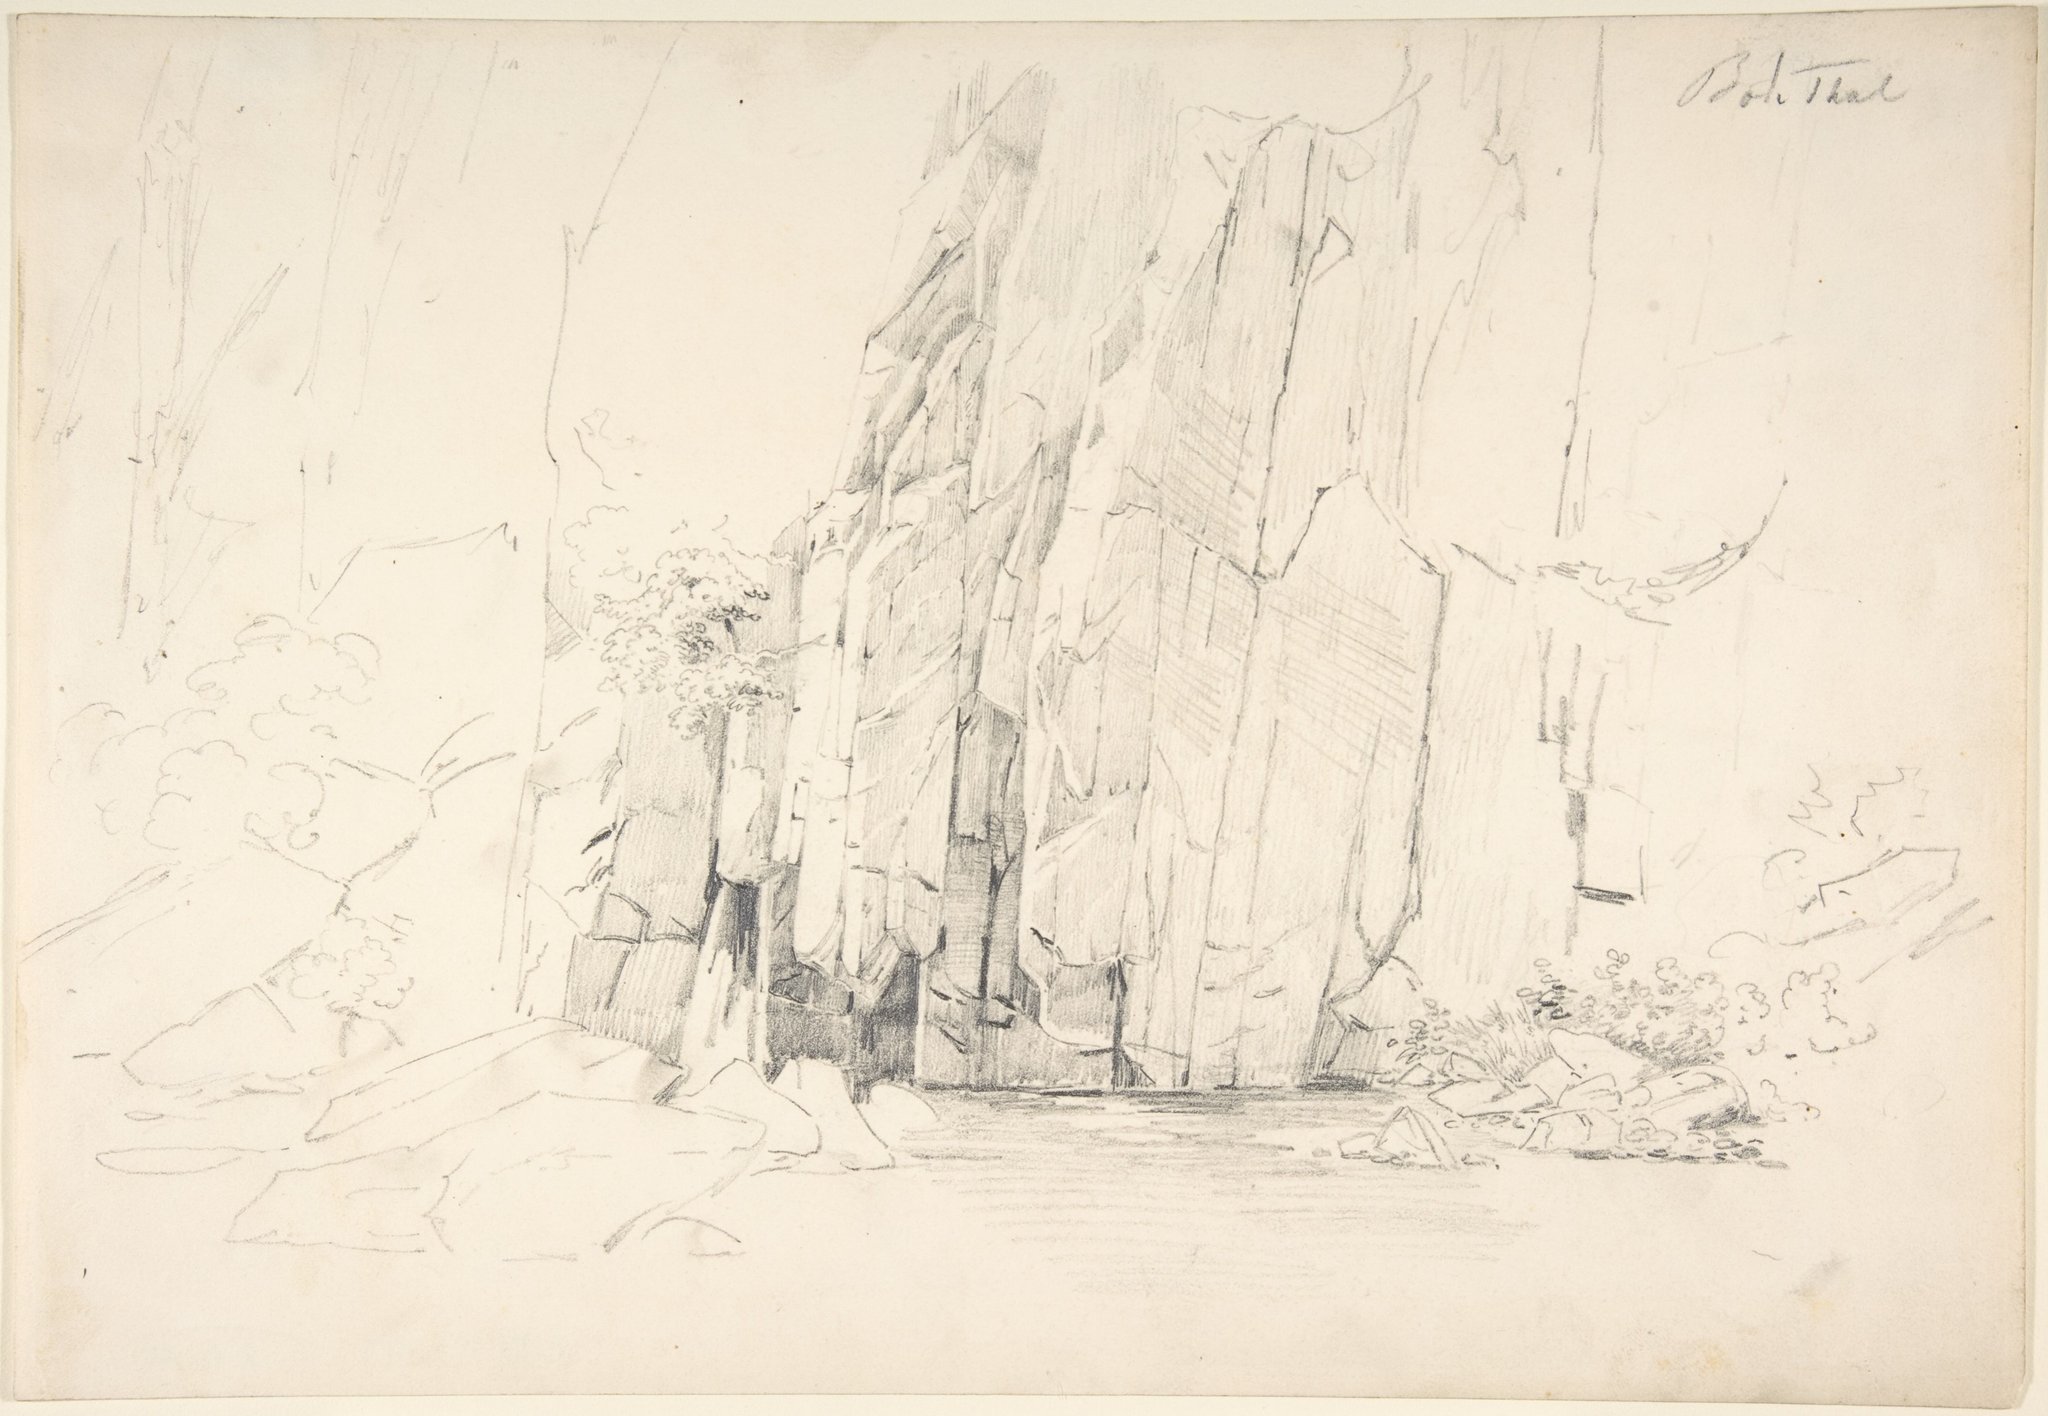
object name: drawing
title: Rocks in the Bode Valley; verso: Small Landscape Studies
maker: karl blechen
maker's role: artist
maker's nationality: german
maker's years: 1798-1840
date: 1800-1840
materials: graphite